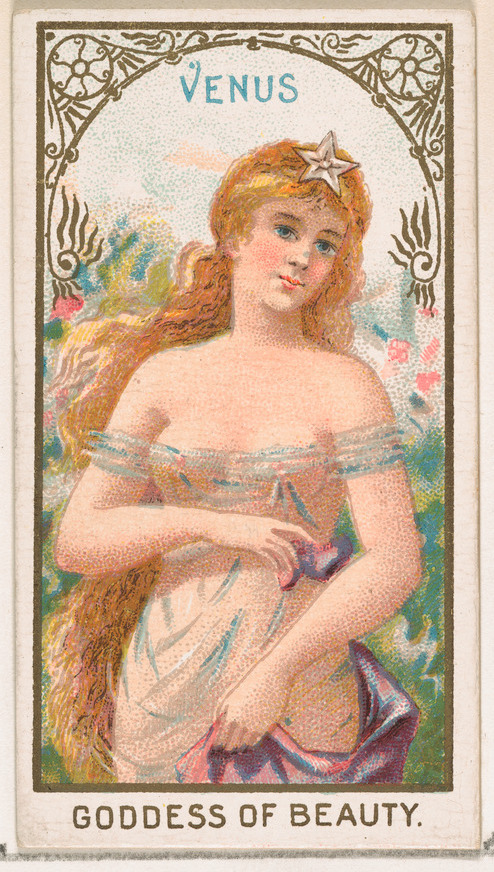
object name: print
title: Venus, Goddess of Beauty, from the Goddesses of the Greeks and Romans series (N188) issued by Wm. S. Kimball & Co.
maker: william s. kimball & company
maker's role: publisher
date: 1889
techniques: color lithograph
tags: venus,goddess